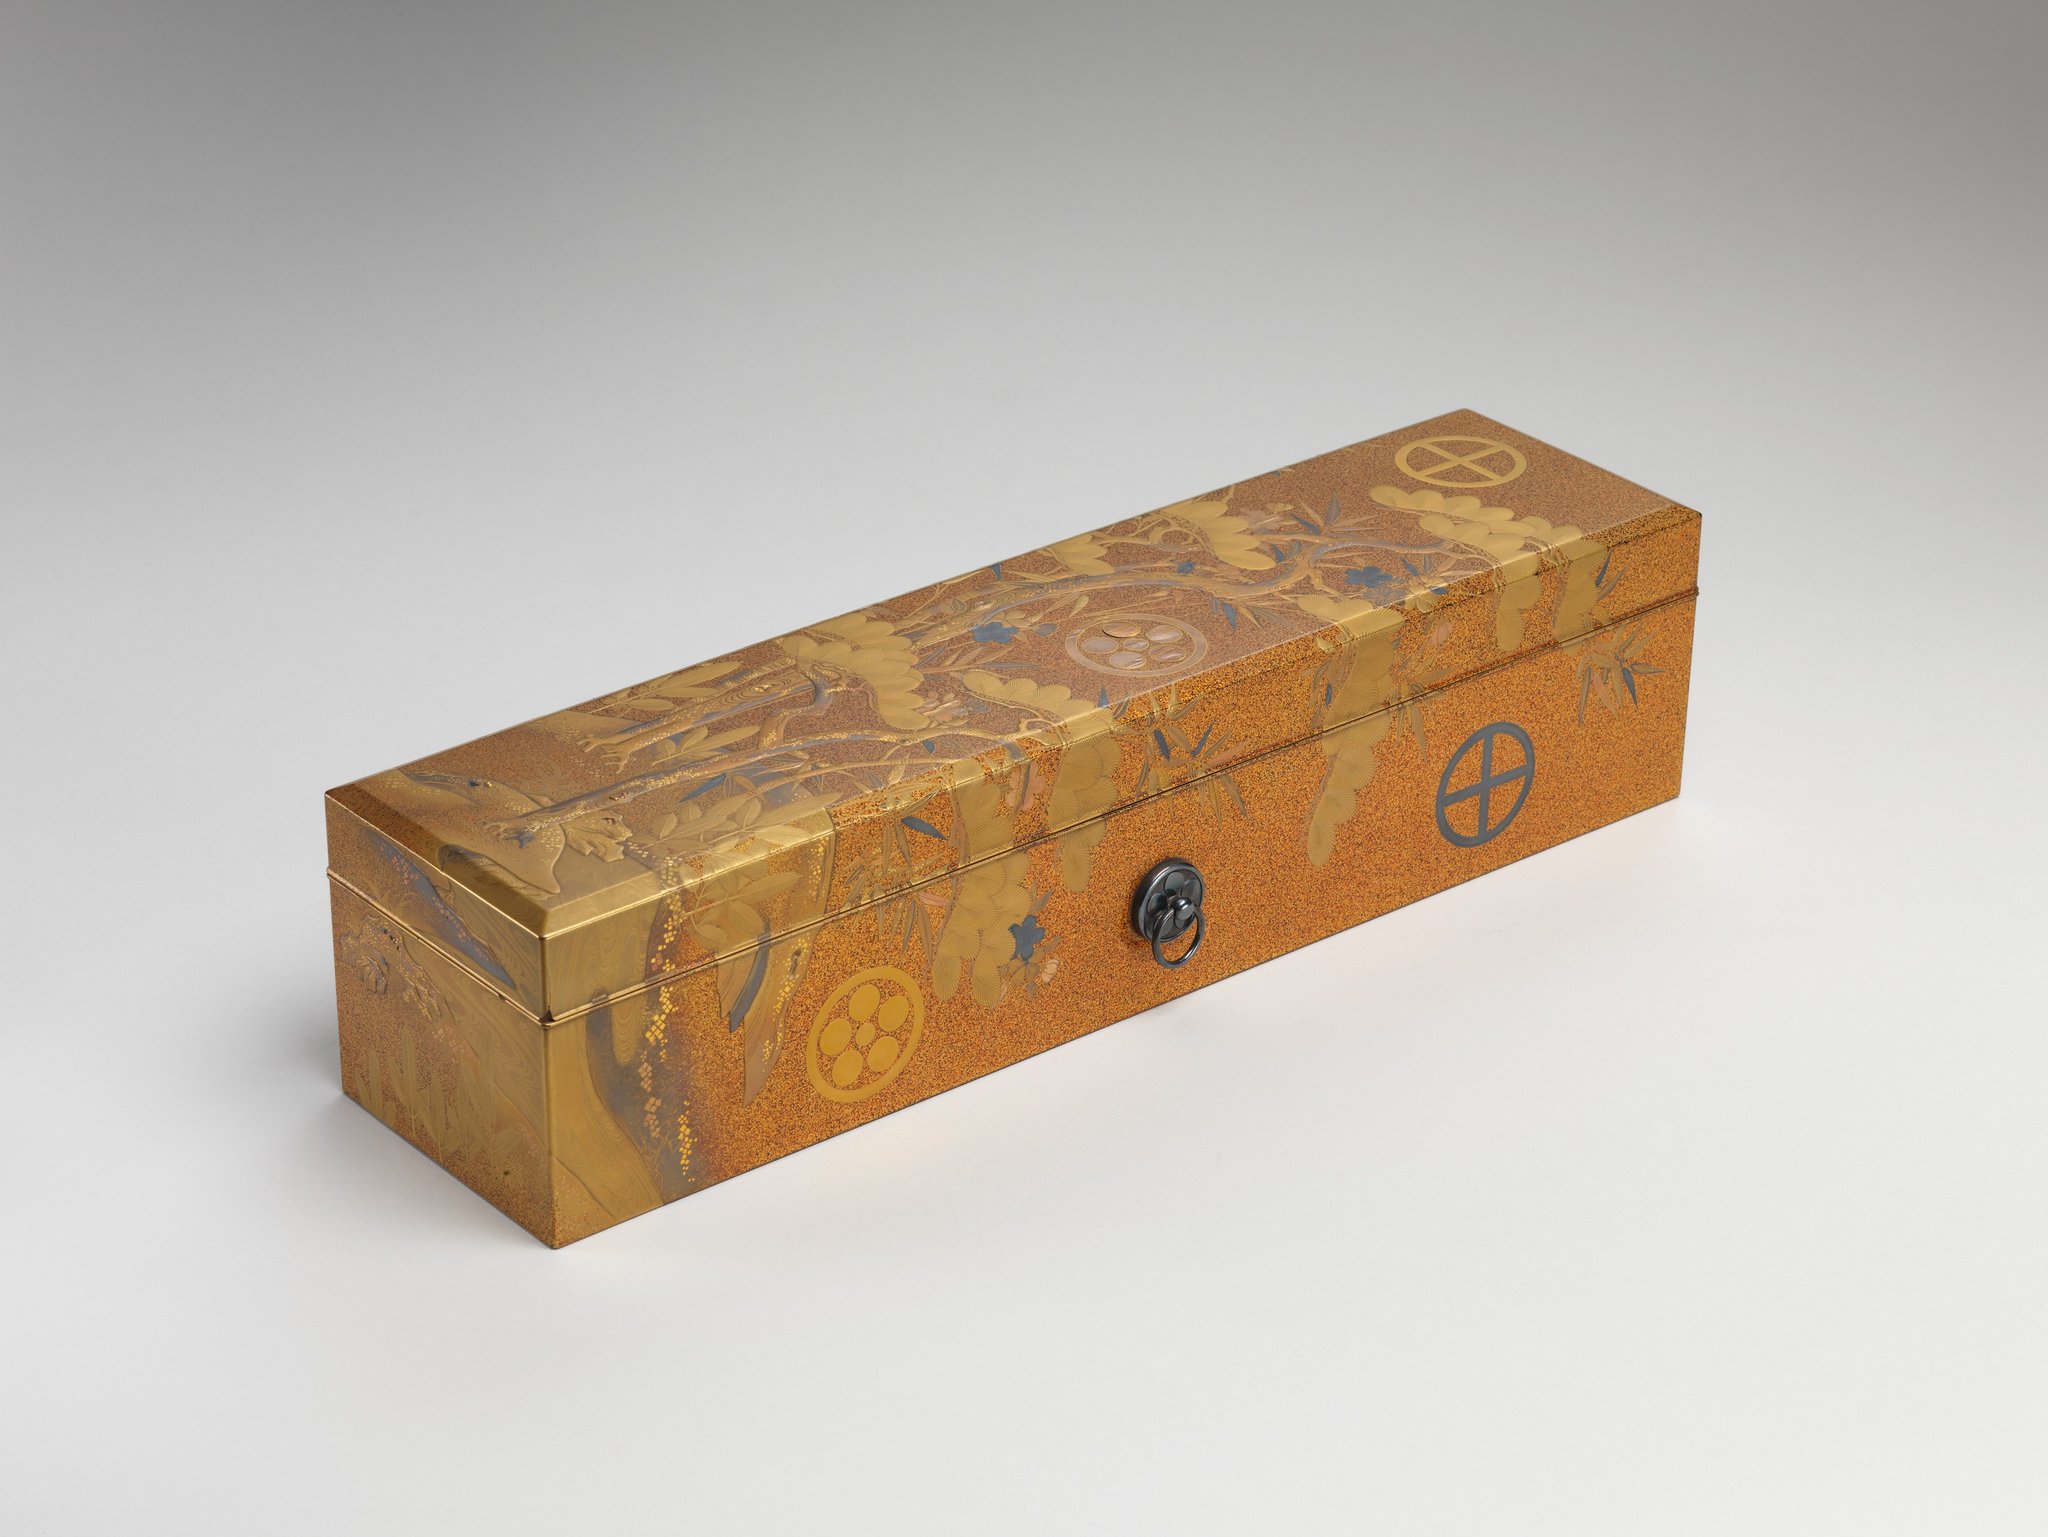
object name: dispatch box with cover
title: Box with Design of Pine, Bamboo, and Cherry Blossom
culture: japanese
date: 1801-1900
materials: gold, lacquer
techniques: maki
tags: flowers,leaves